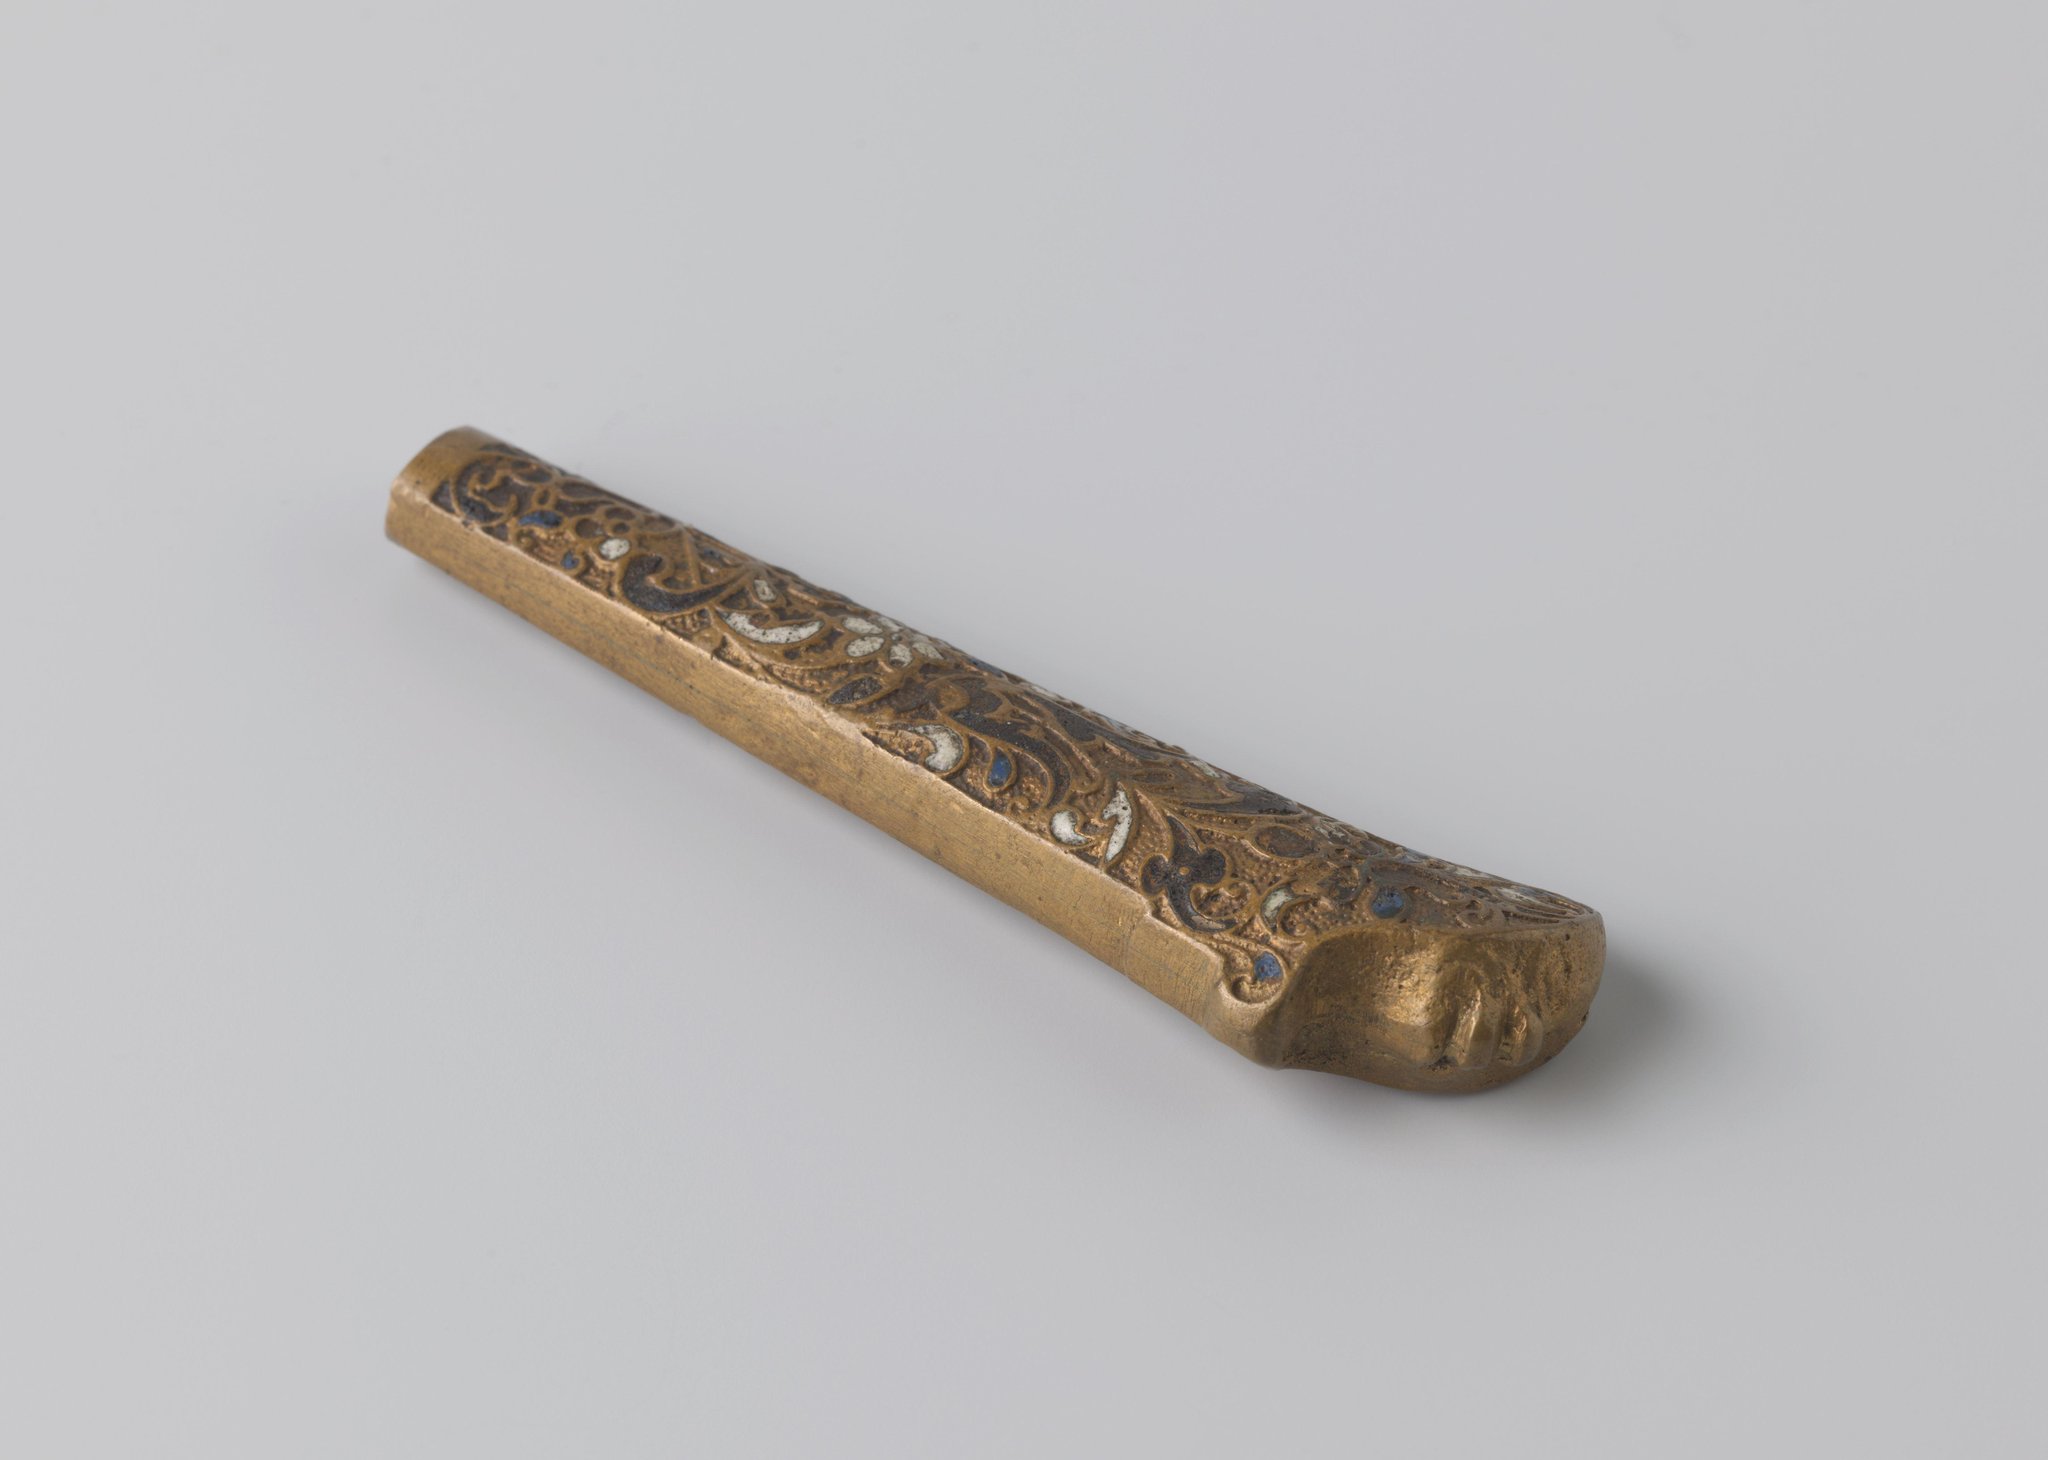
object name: knife handle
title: Messenheft met bloemen in email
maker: Anonymous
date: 1600-1700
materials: copper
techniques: enamel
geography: western europe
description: Messenheft van koper versierd met bloem- en rankmotieven van gekleurd email.